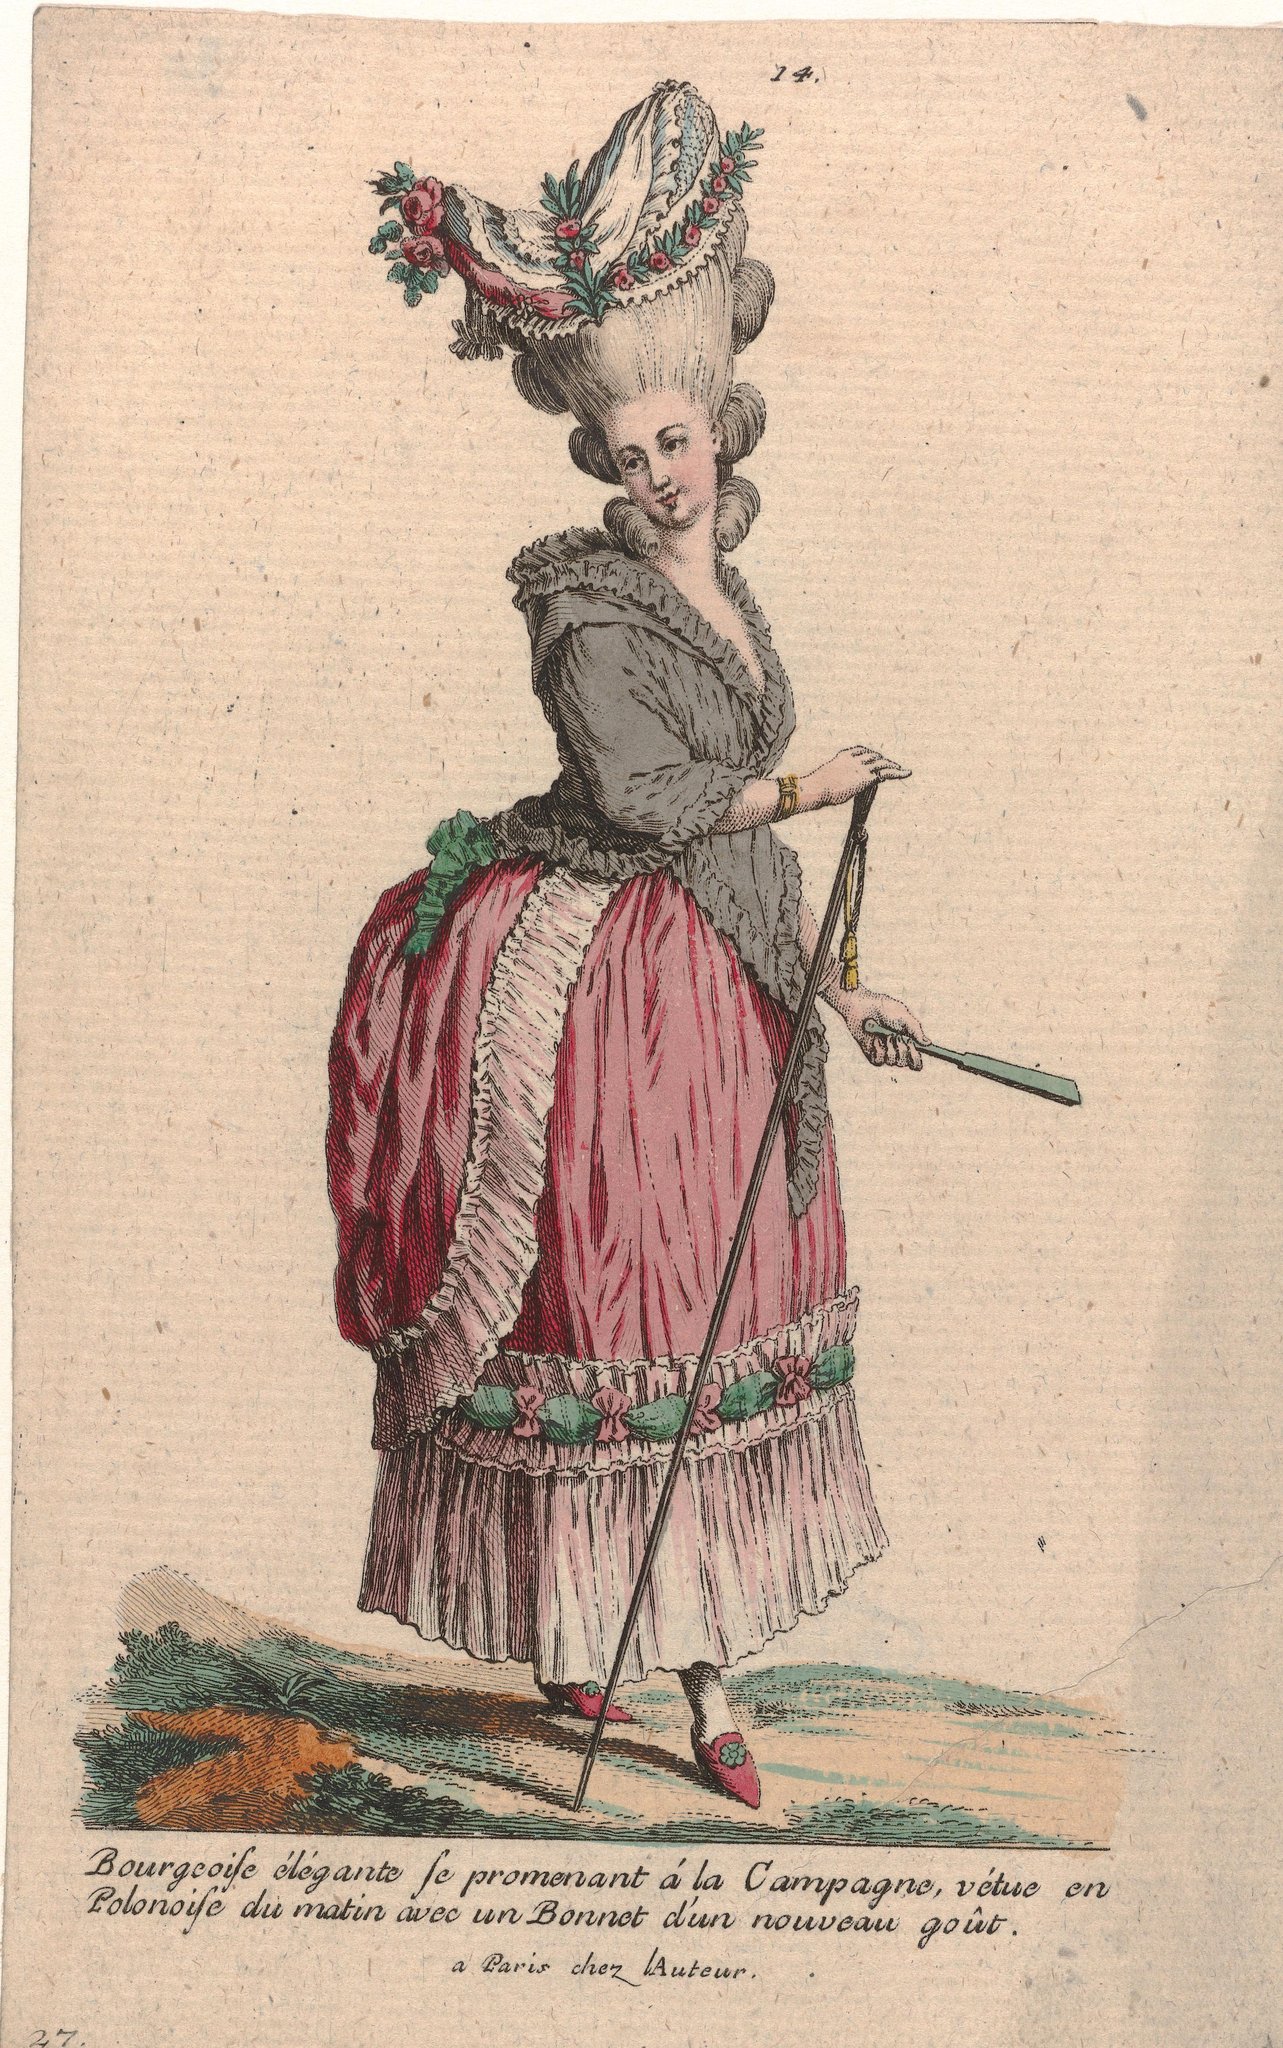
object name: fashion print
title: Gallerie des Modes et Costumes Français, 1785, nr. 14, nr. 27, Kopie naar J 53 : Bourgeoise élégante se promenant (...)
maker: pierre gleich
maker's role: print maker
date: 1785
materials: paper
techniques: engraving, hand coloring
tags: clothing for the upper part of the body (+ women's clothes), walking-stick, staff, cane (+ women's clothes), head-gear: cap (+ women's clothes), fashion plates, shoes, sandals (+ women's clothes), skirt (+ women's clothes), fan (+ women's clothes), dress, gown: robe à la polonaise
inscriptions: caption: ‘a Paris chez l'Auteur’, caption: ‘Bourgeoise élégante se promenant à la Campagne, vétue en Polonoise du matin avec un Bonnet d'un nouveau goût.’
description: Elegante vrouw uit de burgerij wandelend op het platteland, gekleed in een 'robe à la Polonaise' voor de ochtend. Mantelet (kleine schoudermantel) met capuchon. Op het hoofd een muts naar de laatste smaak. Accessoires: armbanden, ring, wandelstok met lint en kwasten, waaier, chatelaine, schoenen met hakken en rozetten. Kopie naar J 53 uit serie J. 9e Cahier des Costumes Français, 3e Suite d'Habillemens à la mode, Gallerie des Modes et Costumes Français.